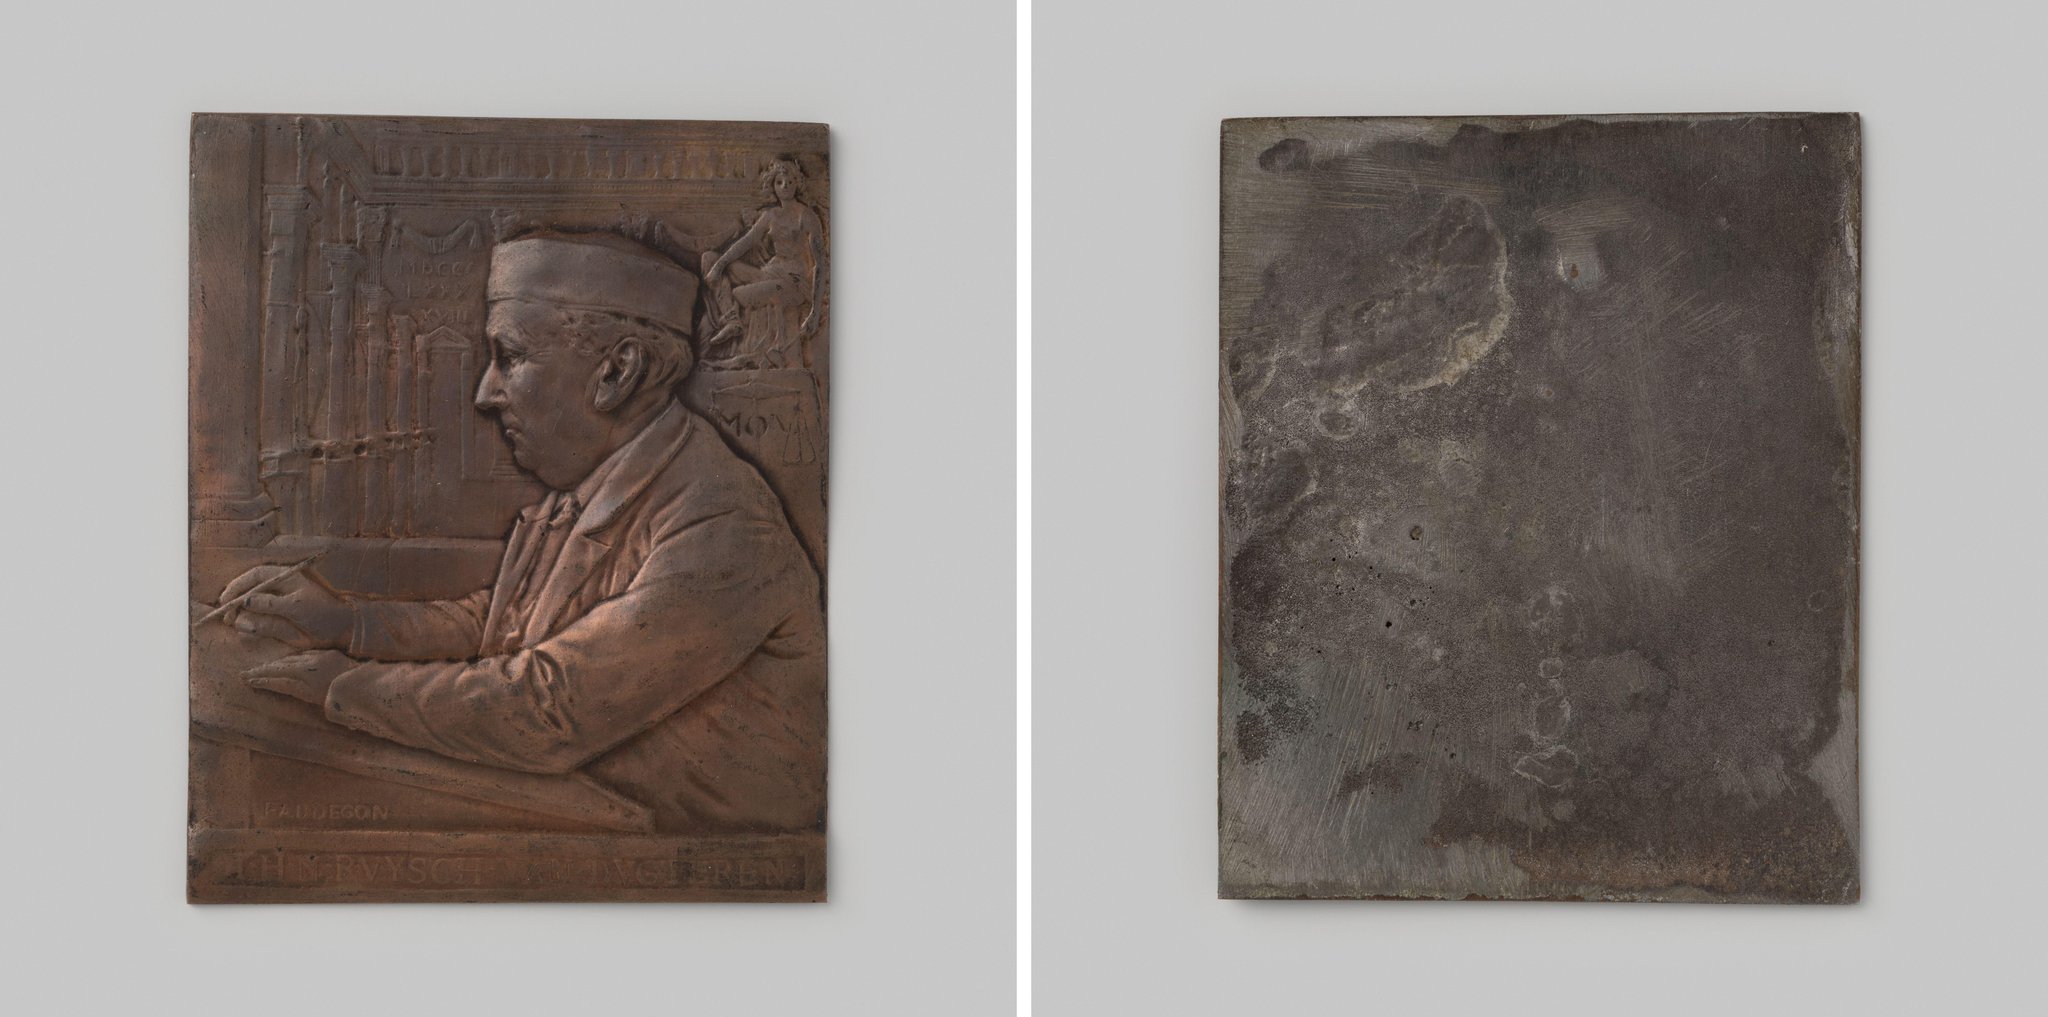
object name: history medal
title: Jubileum van Johan Hendrik Nicolaas Ruijsch van Dugteren provoost van de Muntgezellen van 's Rijks Munt te Utrecht 1898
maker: johan melchior faddegon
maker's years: 1871-1941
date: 1898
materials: zinc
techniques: galvanoplasty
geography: utrecht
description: Rechthoekige deels verbronste plaquette, afgebeeld Ruijsch van Dugteren ten halven lijve naar linkst schrijvend aan een lessenaar, op de achtergrond de muntzaal van 's Rijks Munt en een beeld van Moneta, met onderaan tekstband.